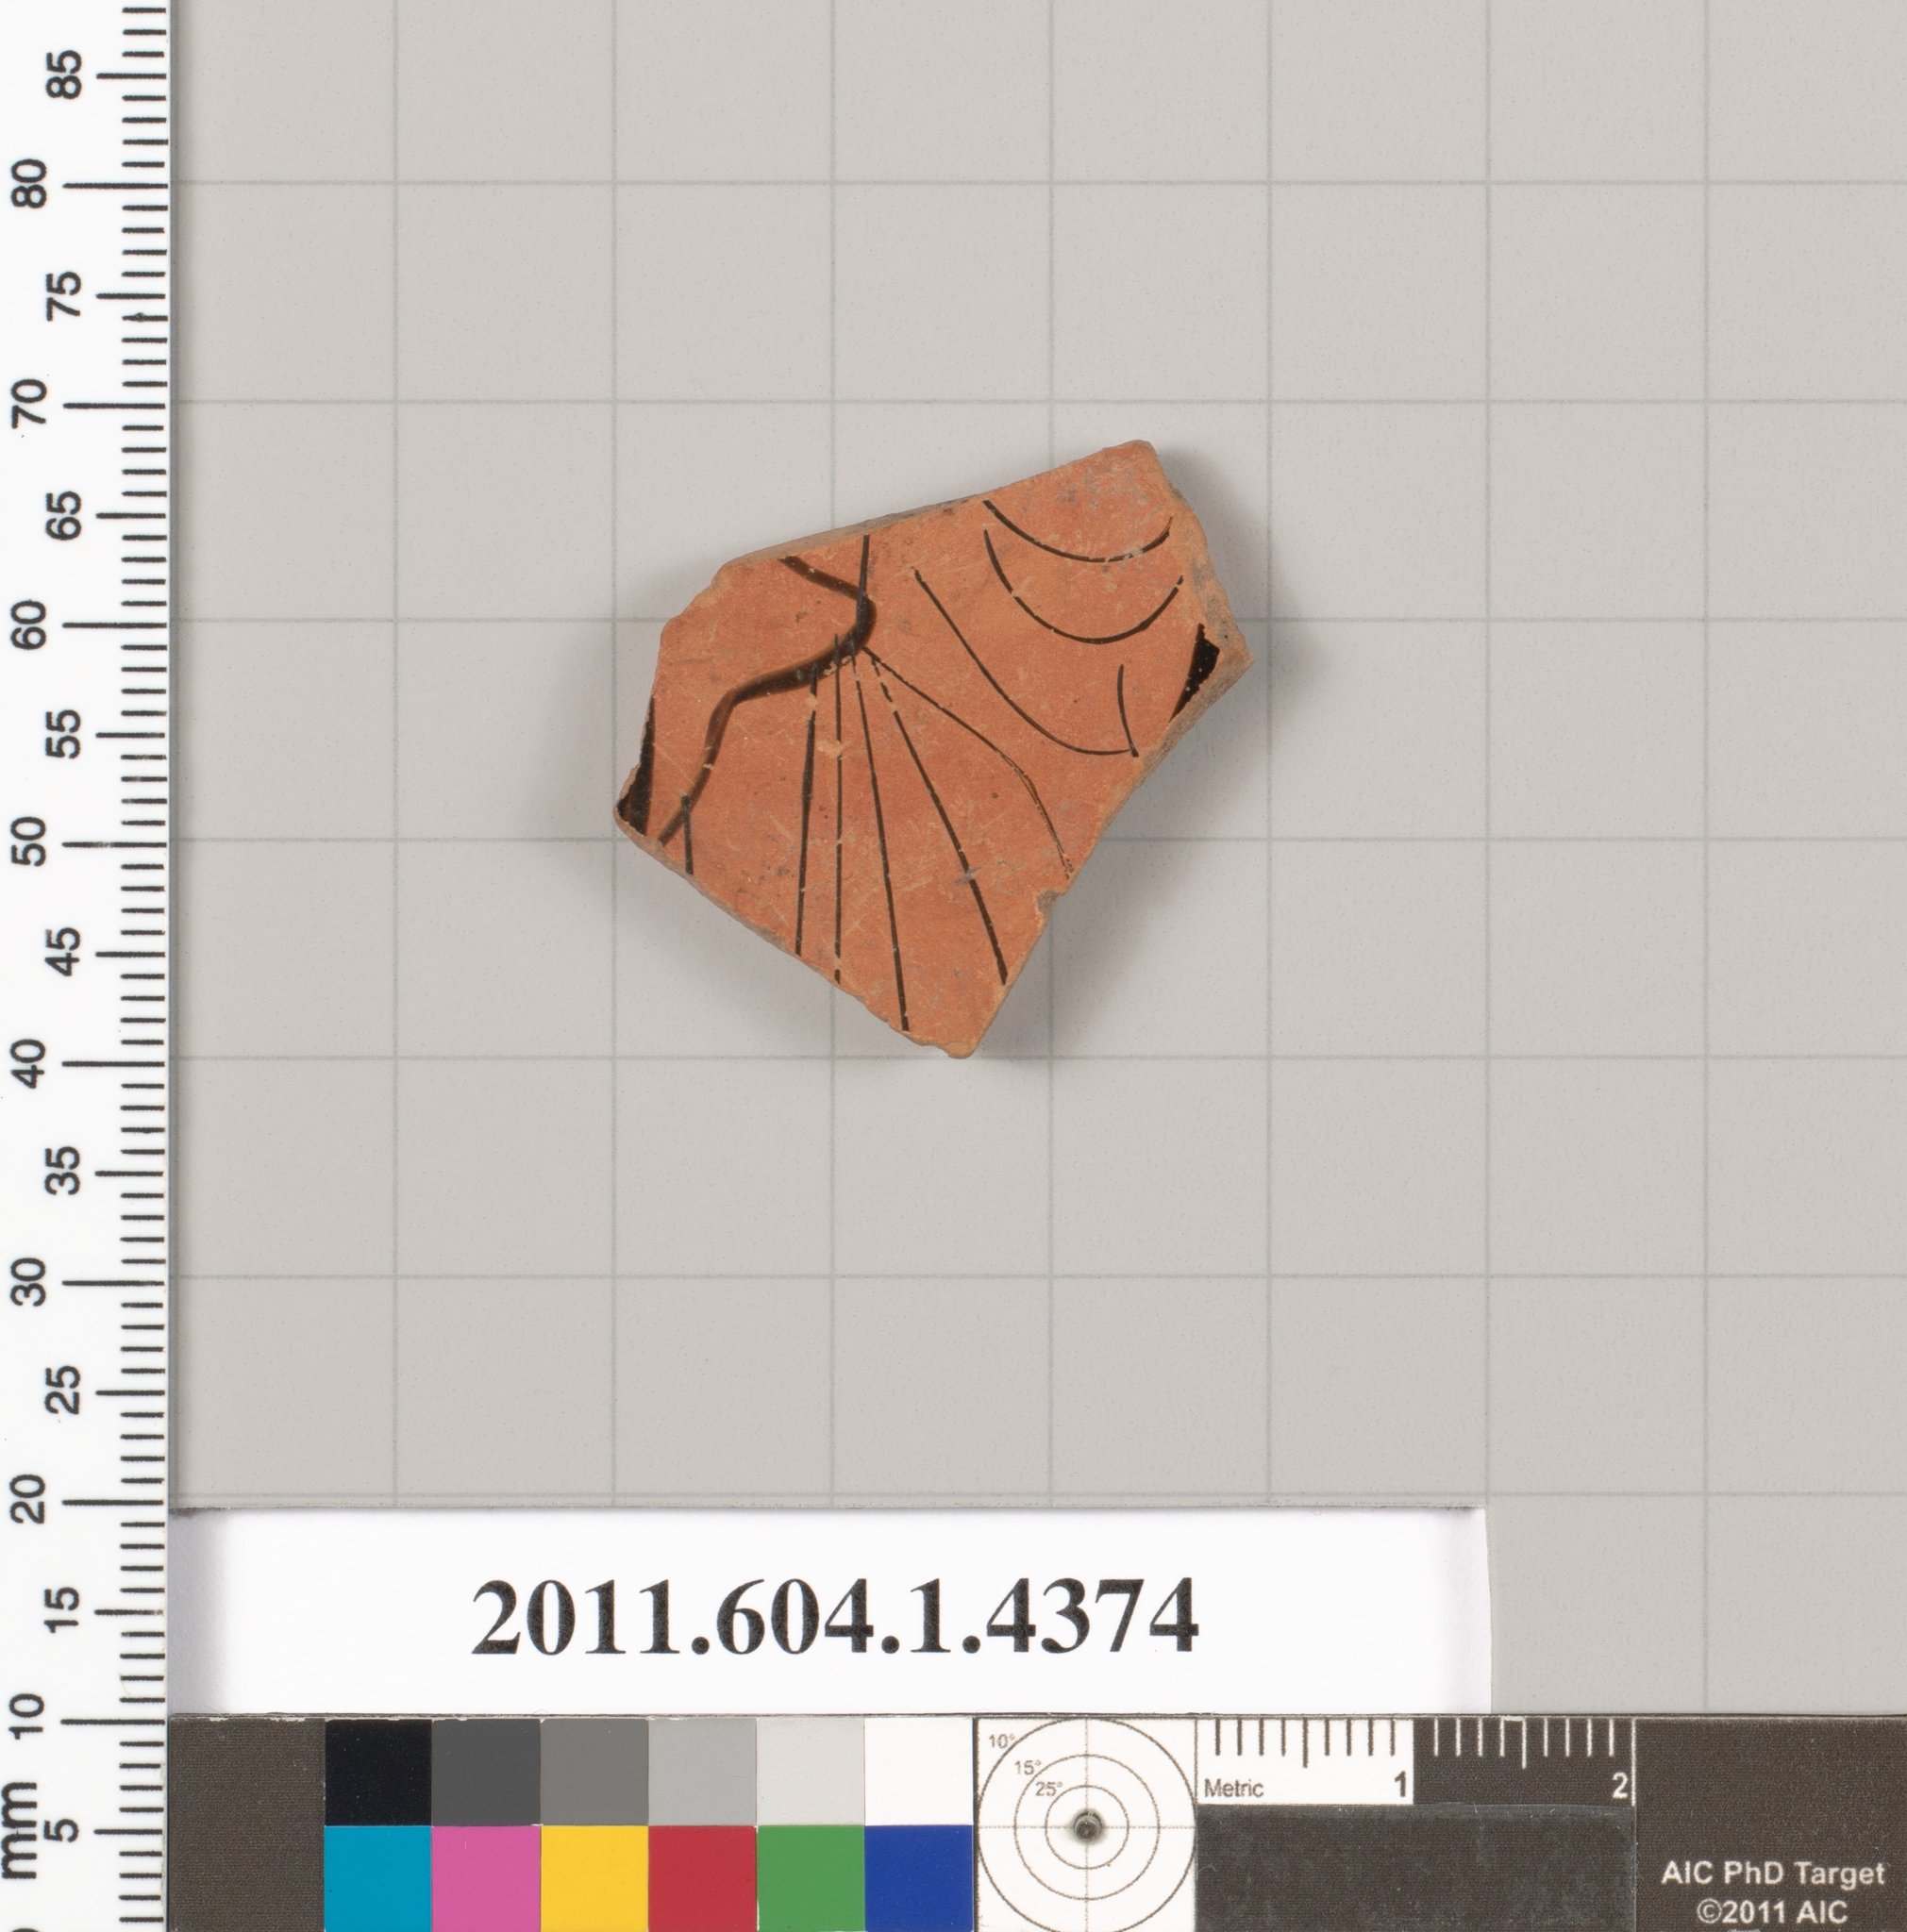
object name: kylix fragment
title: Terracotta fragment of a kylix (drinking cup)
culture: greek, attic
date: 475-451 BCE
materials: terracotta